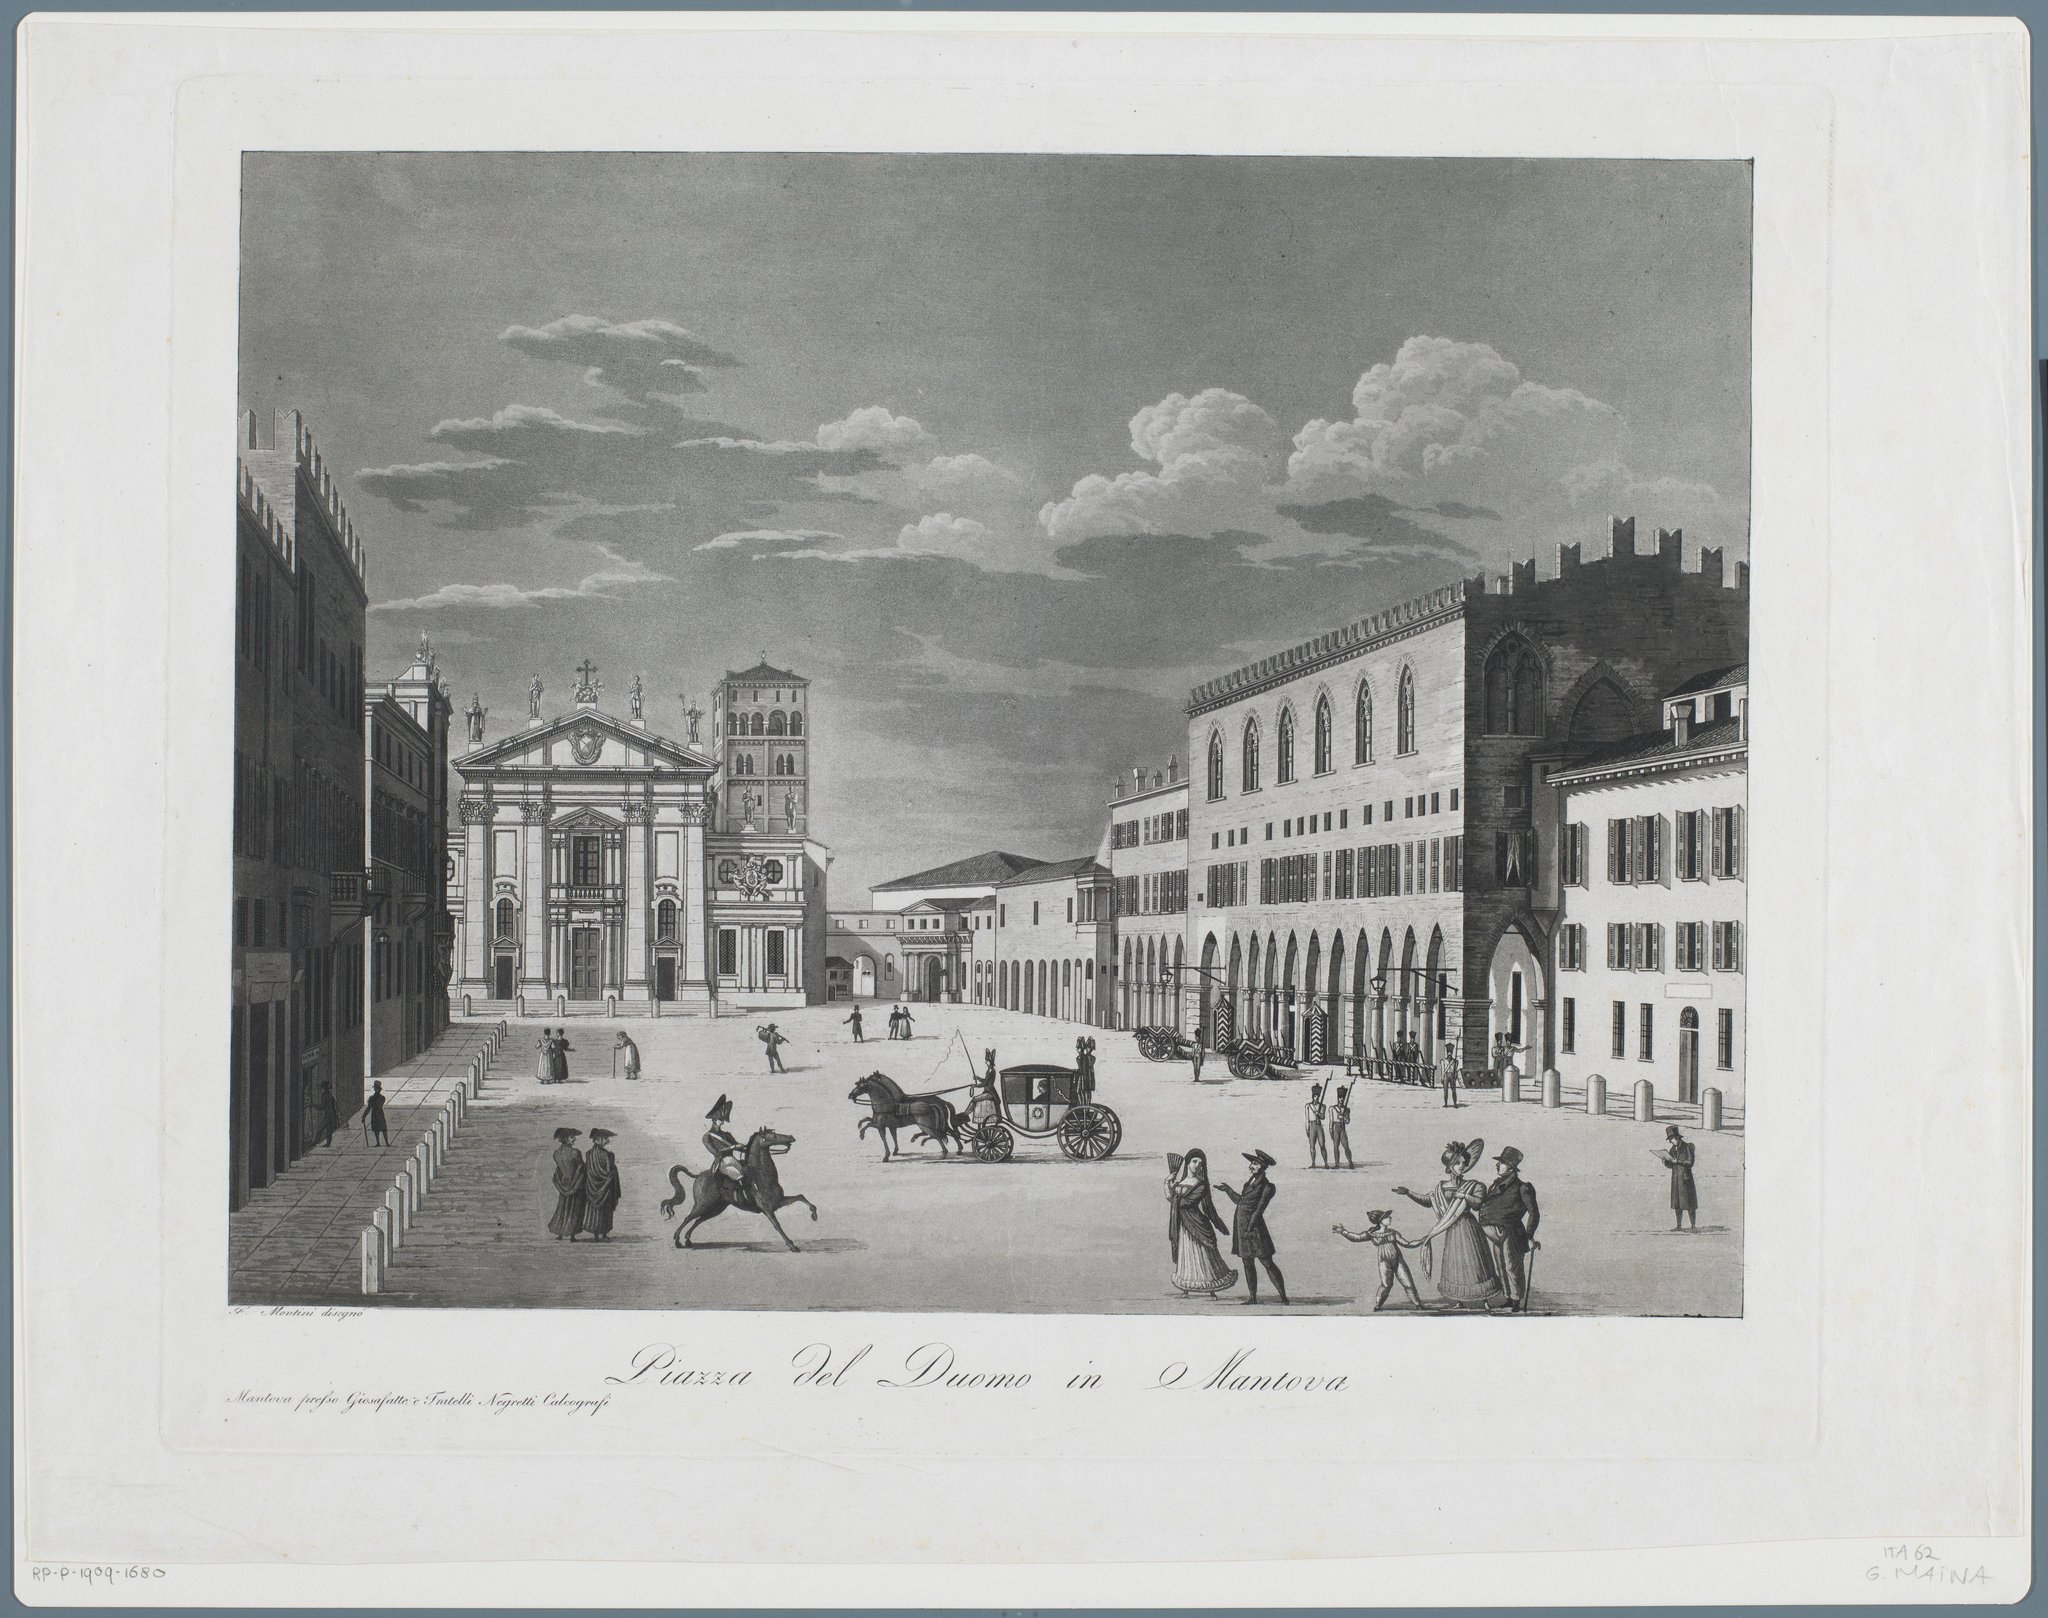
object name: print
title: Piazza Sordello te Mantua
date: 1810-1845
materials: paper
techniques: aquatint, etching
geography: italy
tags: square, place, circus, etc., church (exterior)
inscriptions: collector's mark: Lugt 2228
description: Gezicht op het Piazza Sordello te Mantua. Links de façade van de Dom, rechts het Palazzo del Capitano. Op het plein verscheidene figuren.